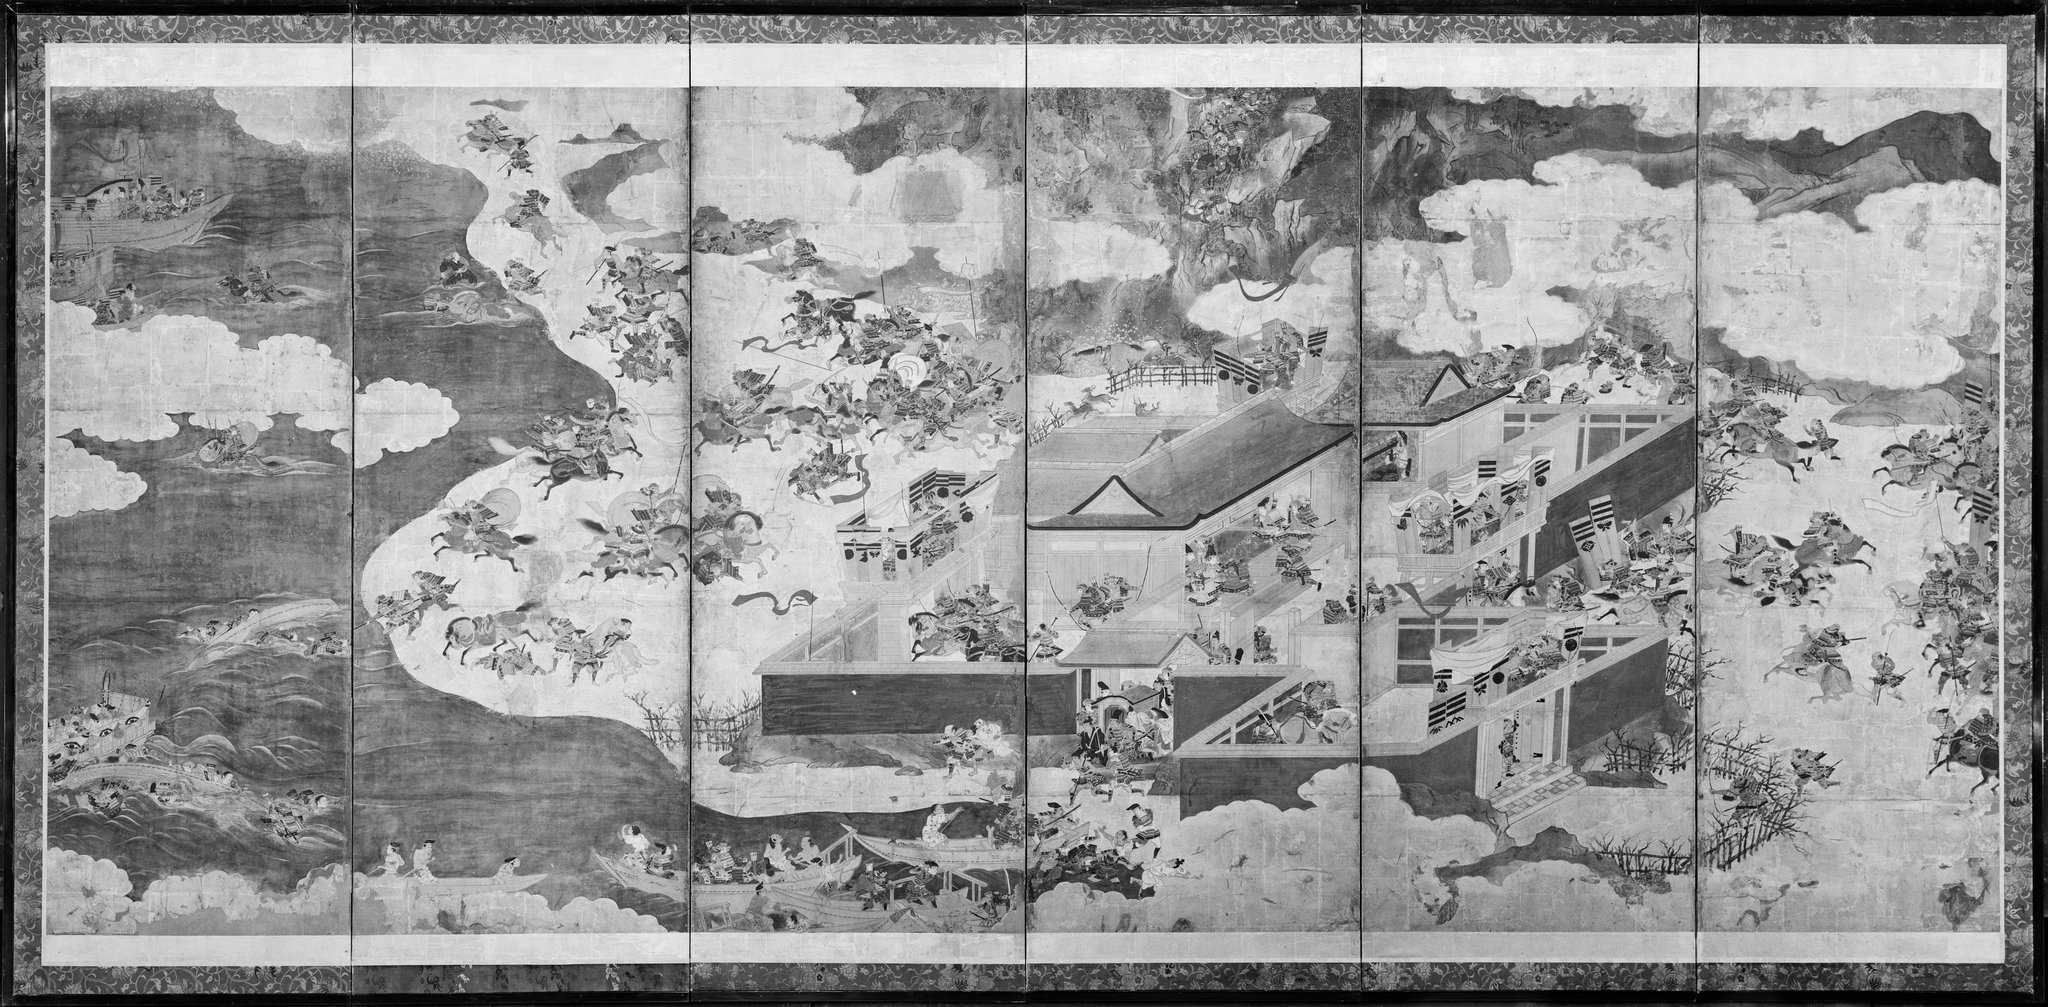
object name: screen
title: The Battle at Ichinotani, from The Tale of the Heike (Heike monogatari)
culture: japanese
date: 1601-1700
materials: gold, gold leaf, ink, panel, paper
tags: battles,army,men,horses